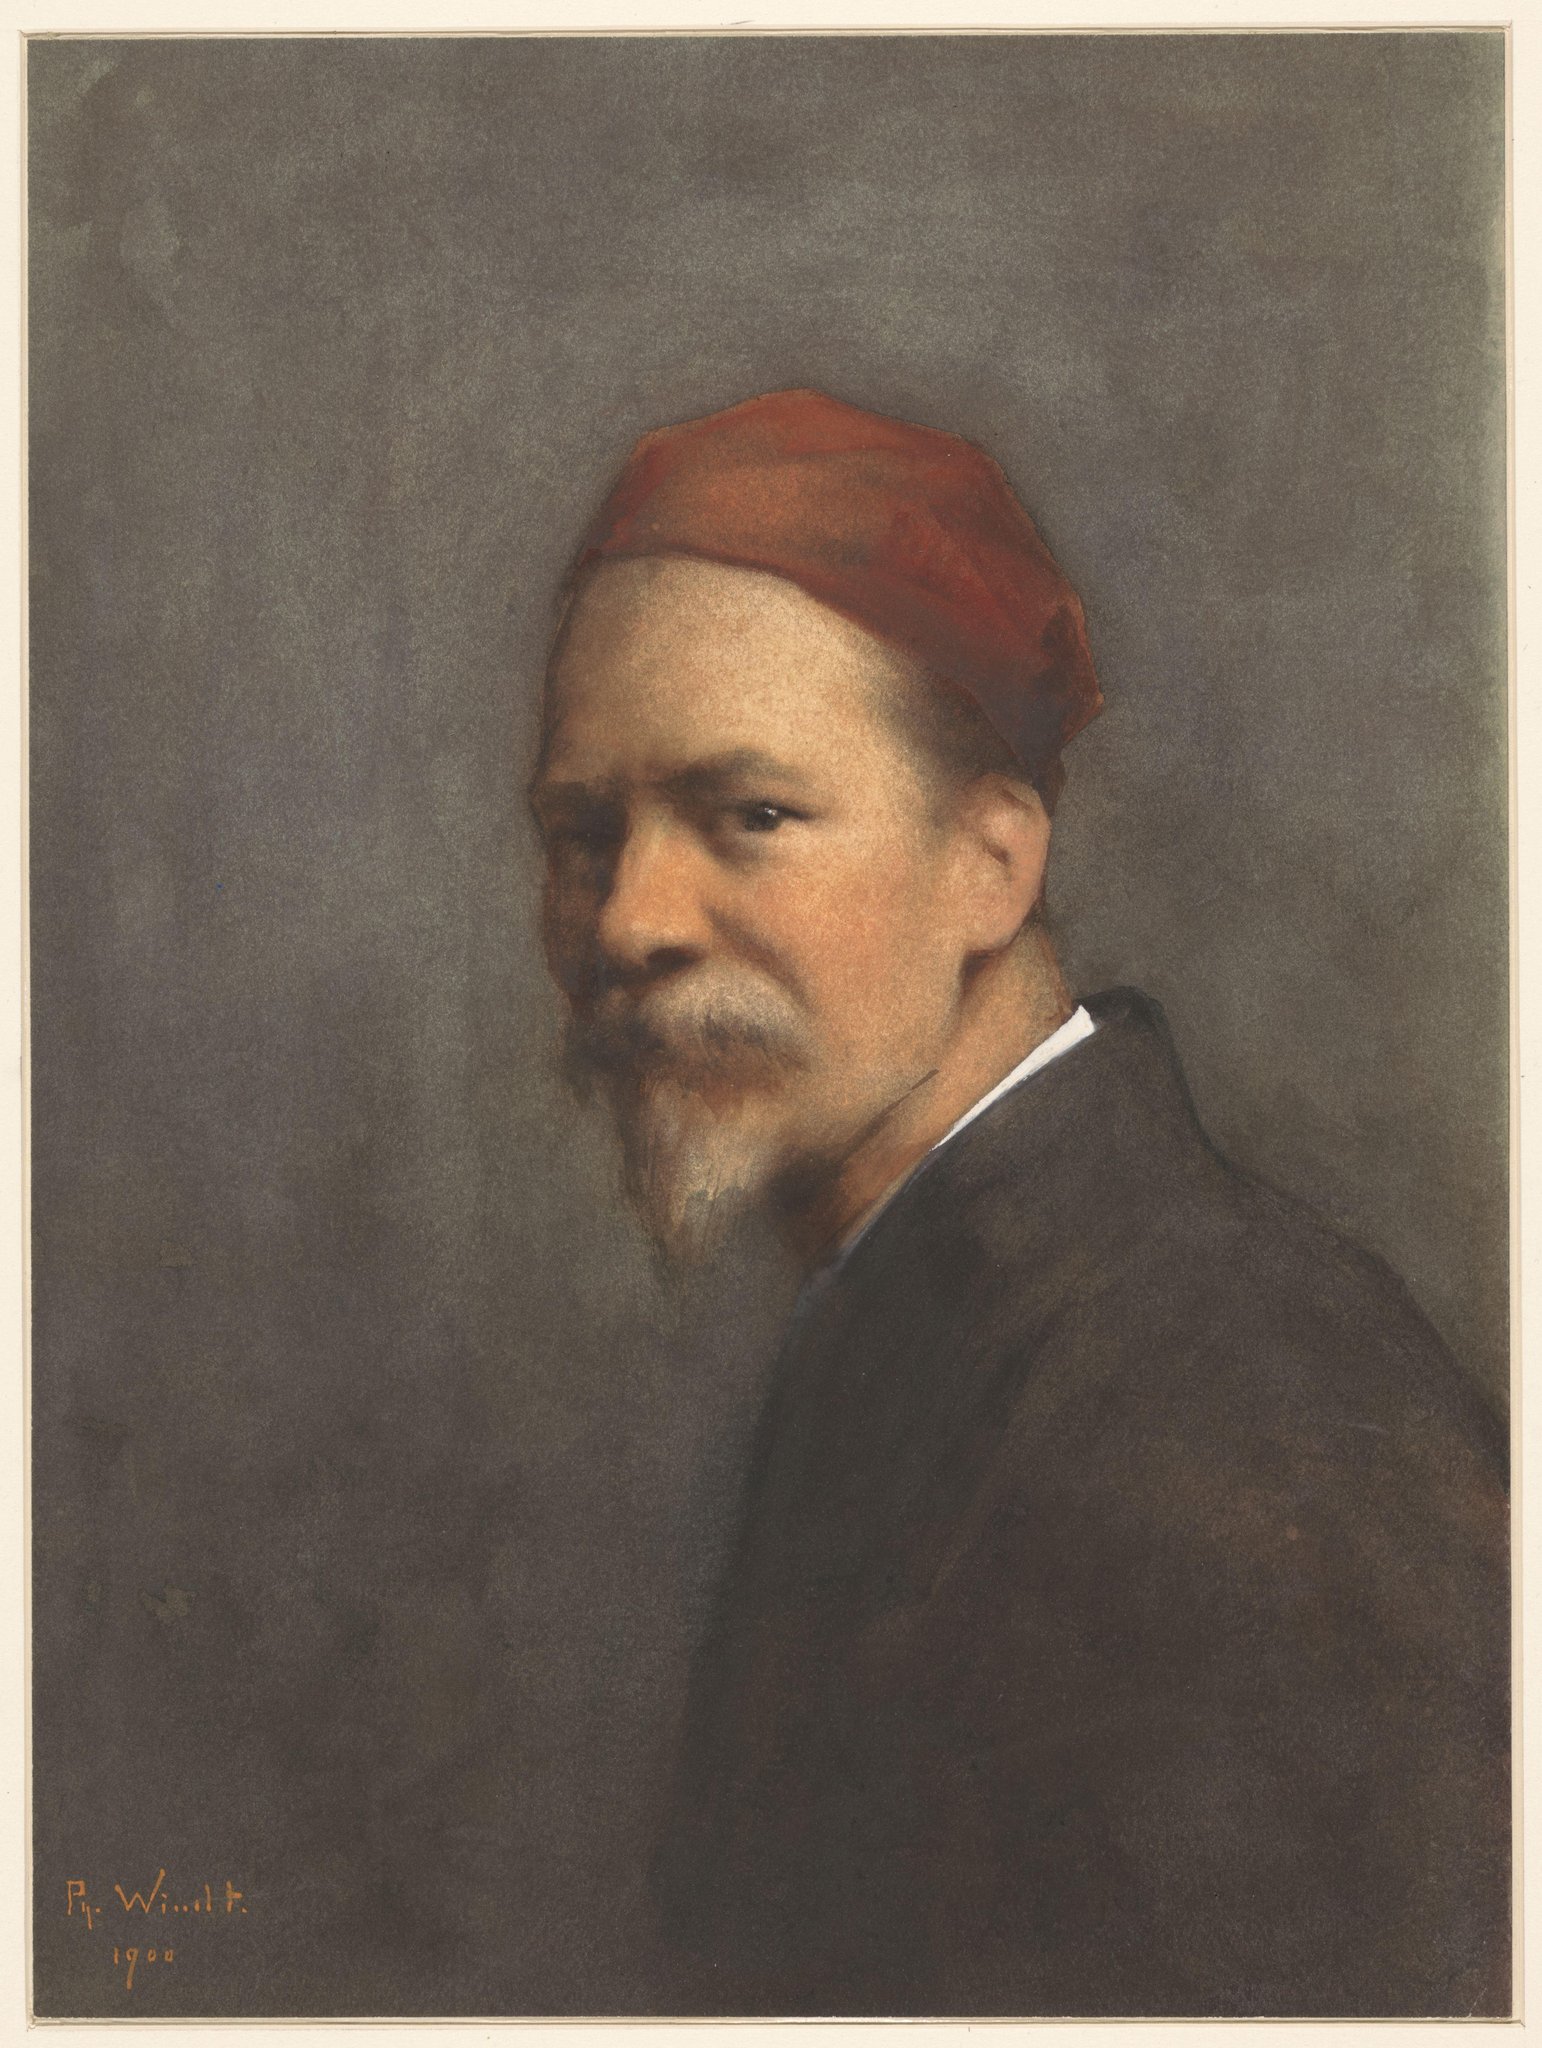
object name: drawing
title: Zelfportret van Philip Windt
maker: philip windt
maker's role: draughtsman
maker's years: 1847-1921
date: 1900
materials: chalk, paper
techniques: brush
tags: the hague, draughtsman, philip windt, historical persons, portrait, self-portrait of artist